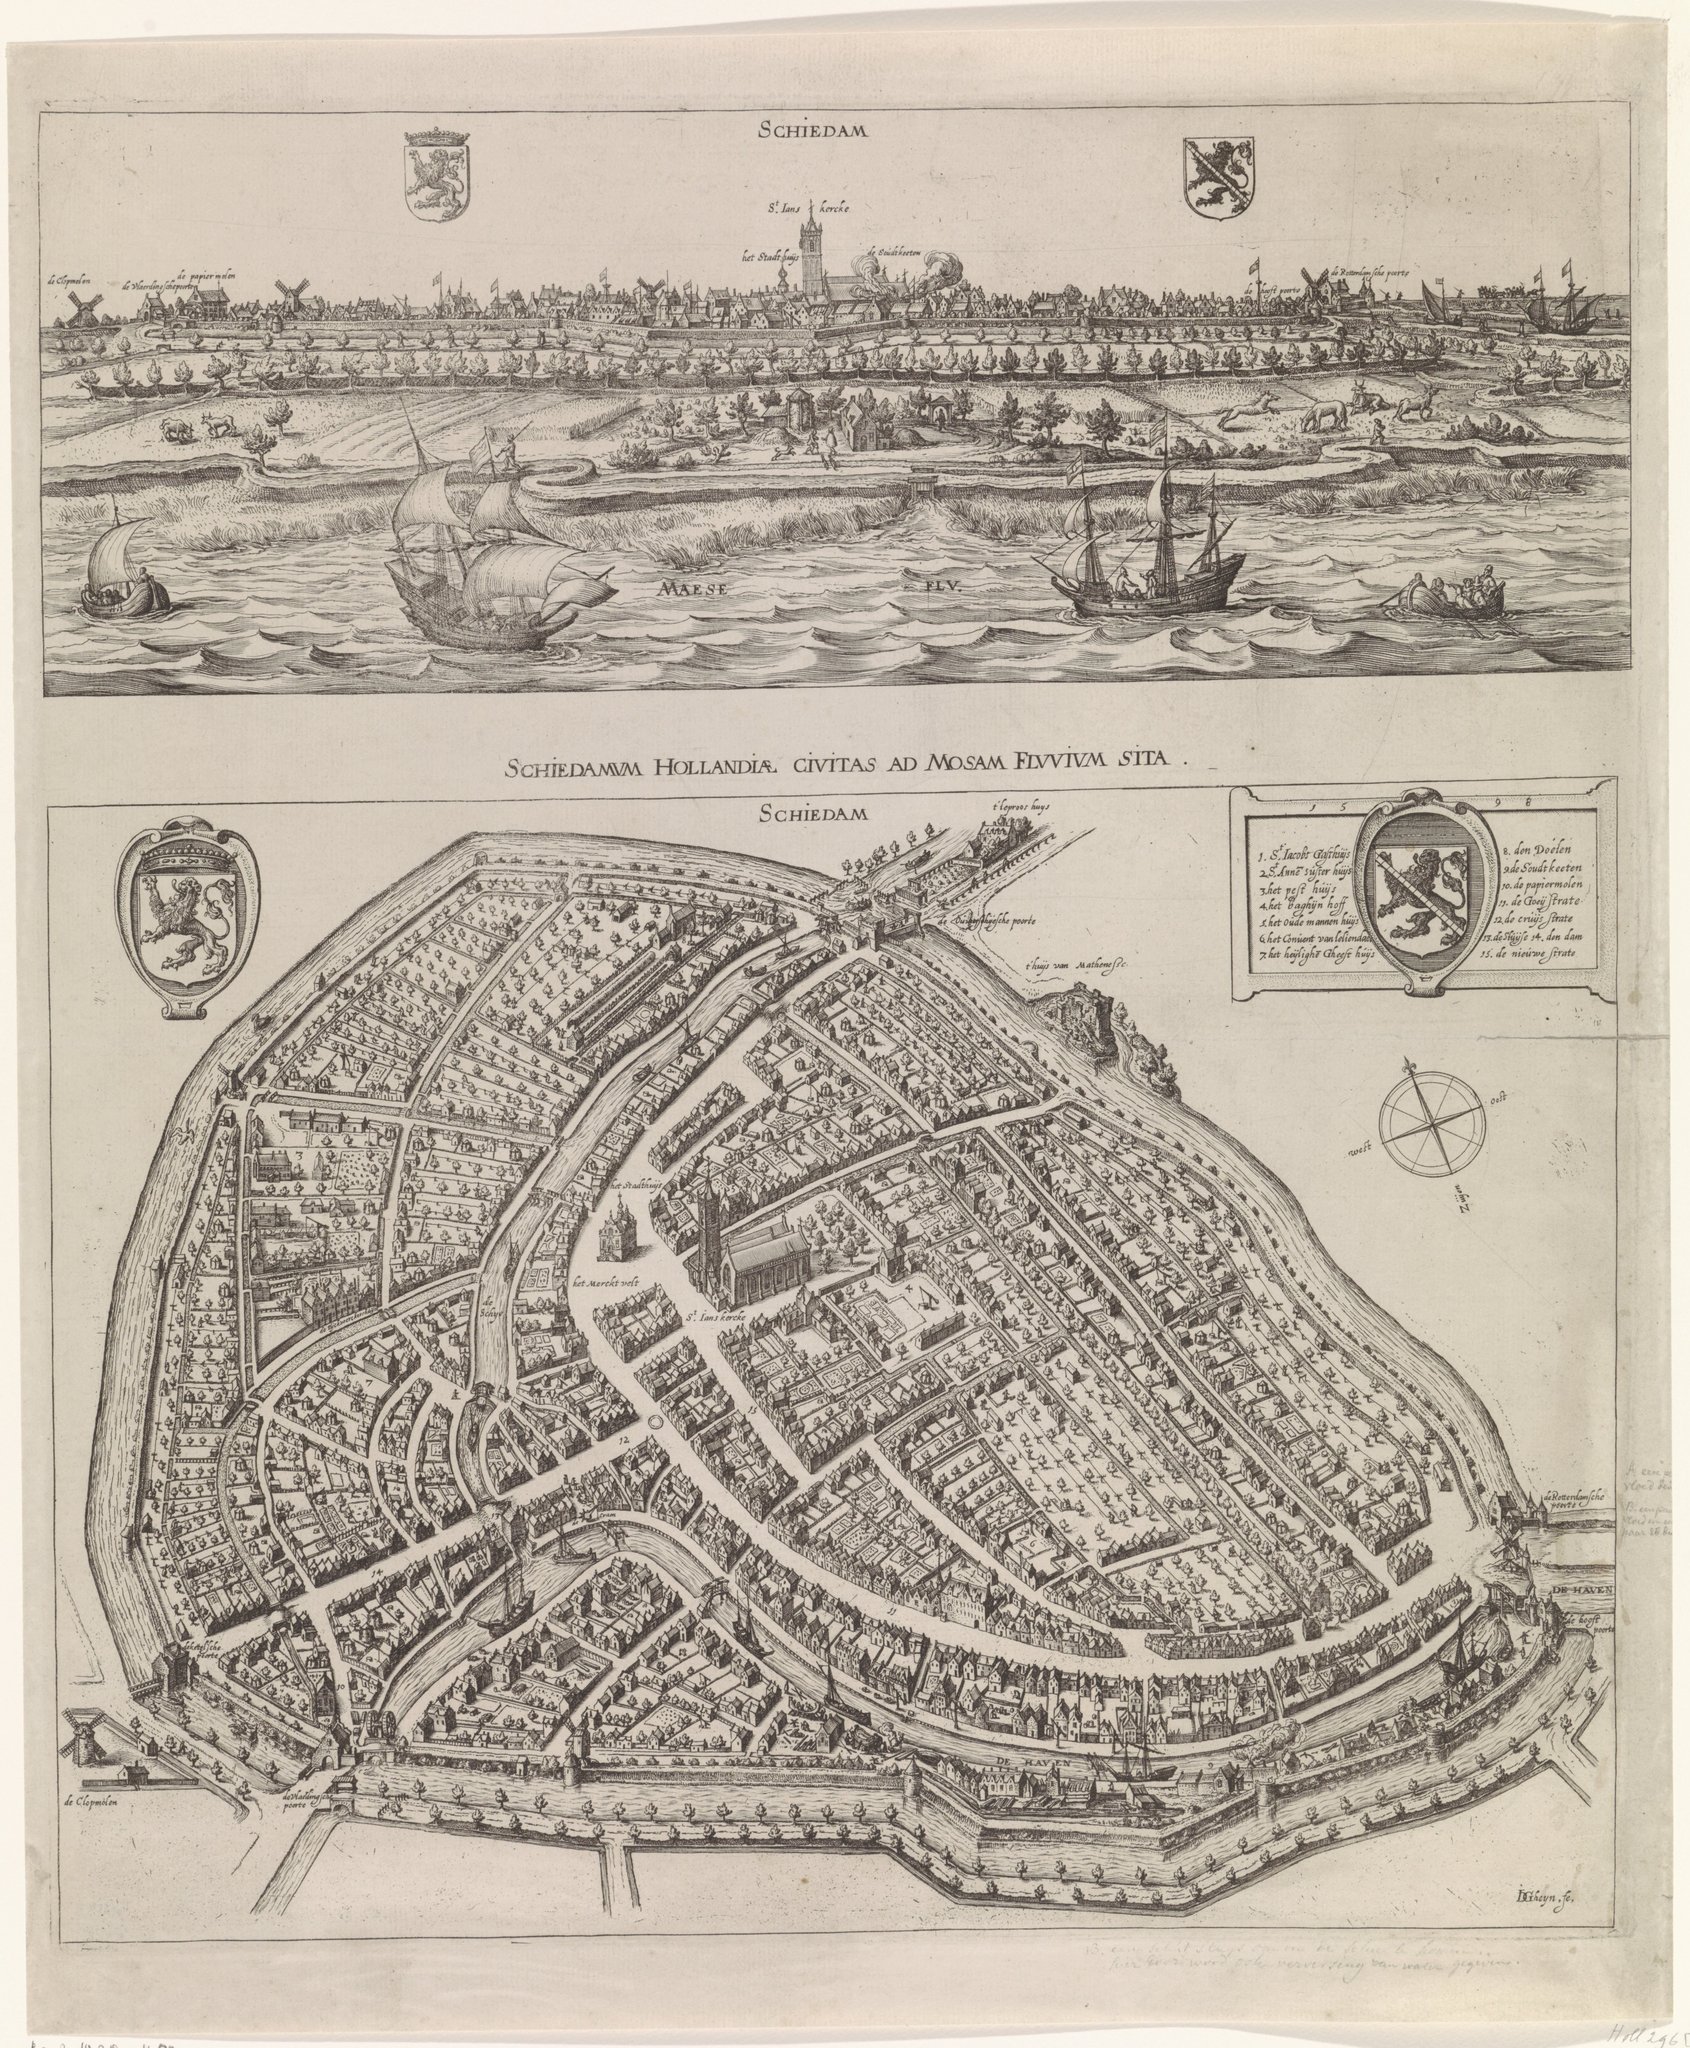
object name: print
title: Panorama en plattegrond van Schiedam, 1598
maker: jacques de gheyn (ii)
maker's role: painter, print maker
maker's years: 1565-1629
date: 1598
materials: paper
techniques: engraving, etching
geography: the hague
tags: city-view in general; 'veduta', maps, atlases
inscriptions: collector's mark: Lugt 2166, collector's mark: 2760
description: Boven een panorama van Schiedam, met op de voorgrond de rivier de Maas en op de achtergrond ondermeer de Sint-Janskerk en het stadhuis. Onder een plattegrond van Schiedam met legende.